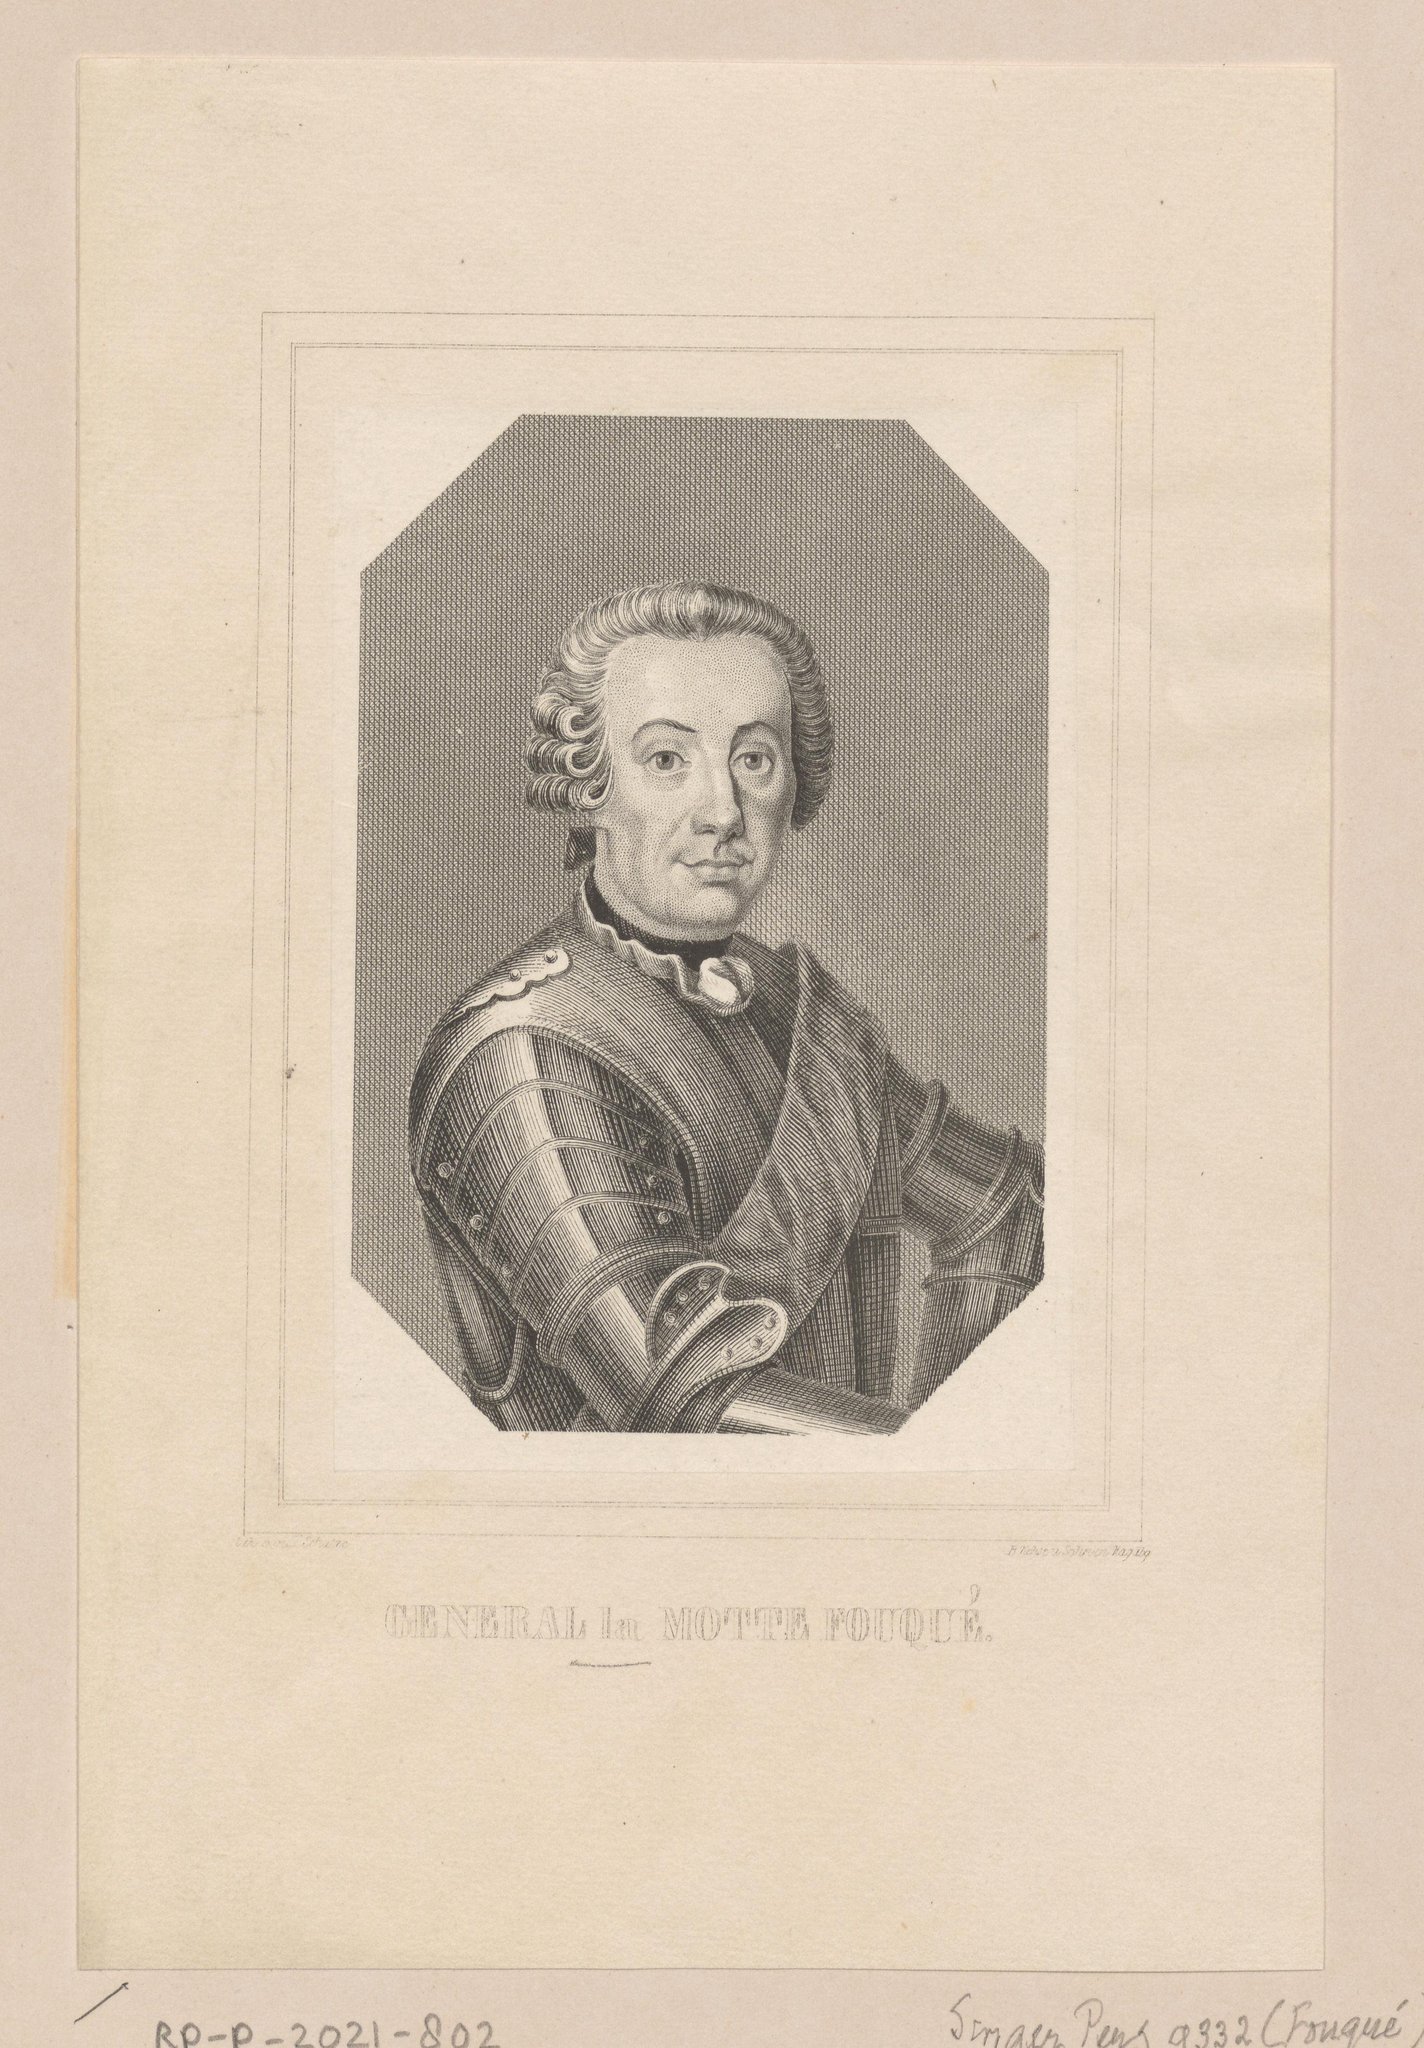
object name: print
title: Portret van Heinrich August de la Motte Fouqué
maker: h. schuetze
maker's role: print maker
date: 1830-1840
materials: paper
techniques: lithograph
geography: magdeburg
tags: the hague, commander-in-chief, general, marshal, armour, historical persons